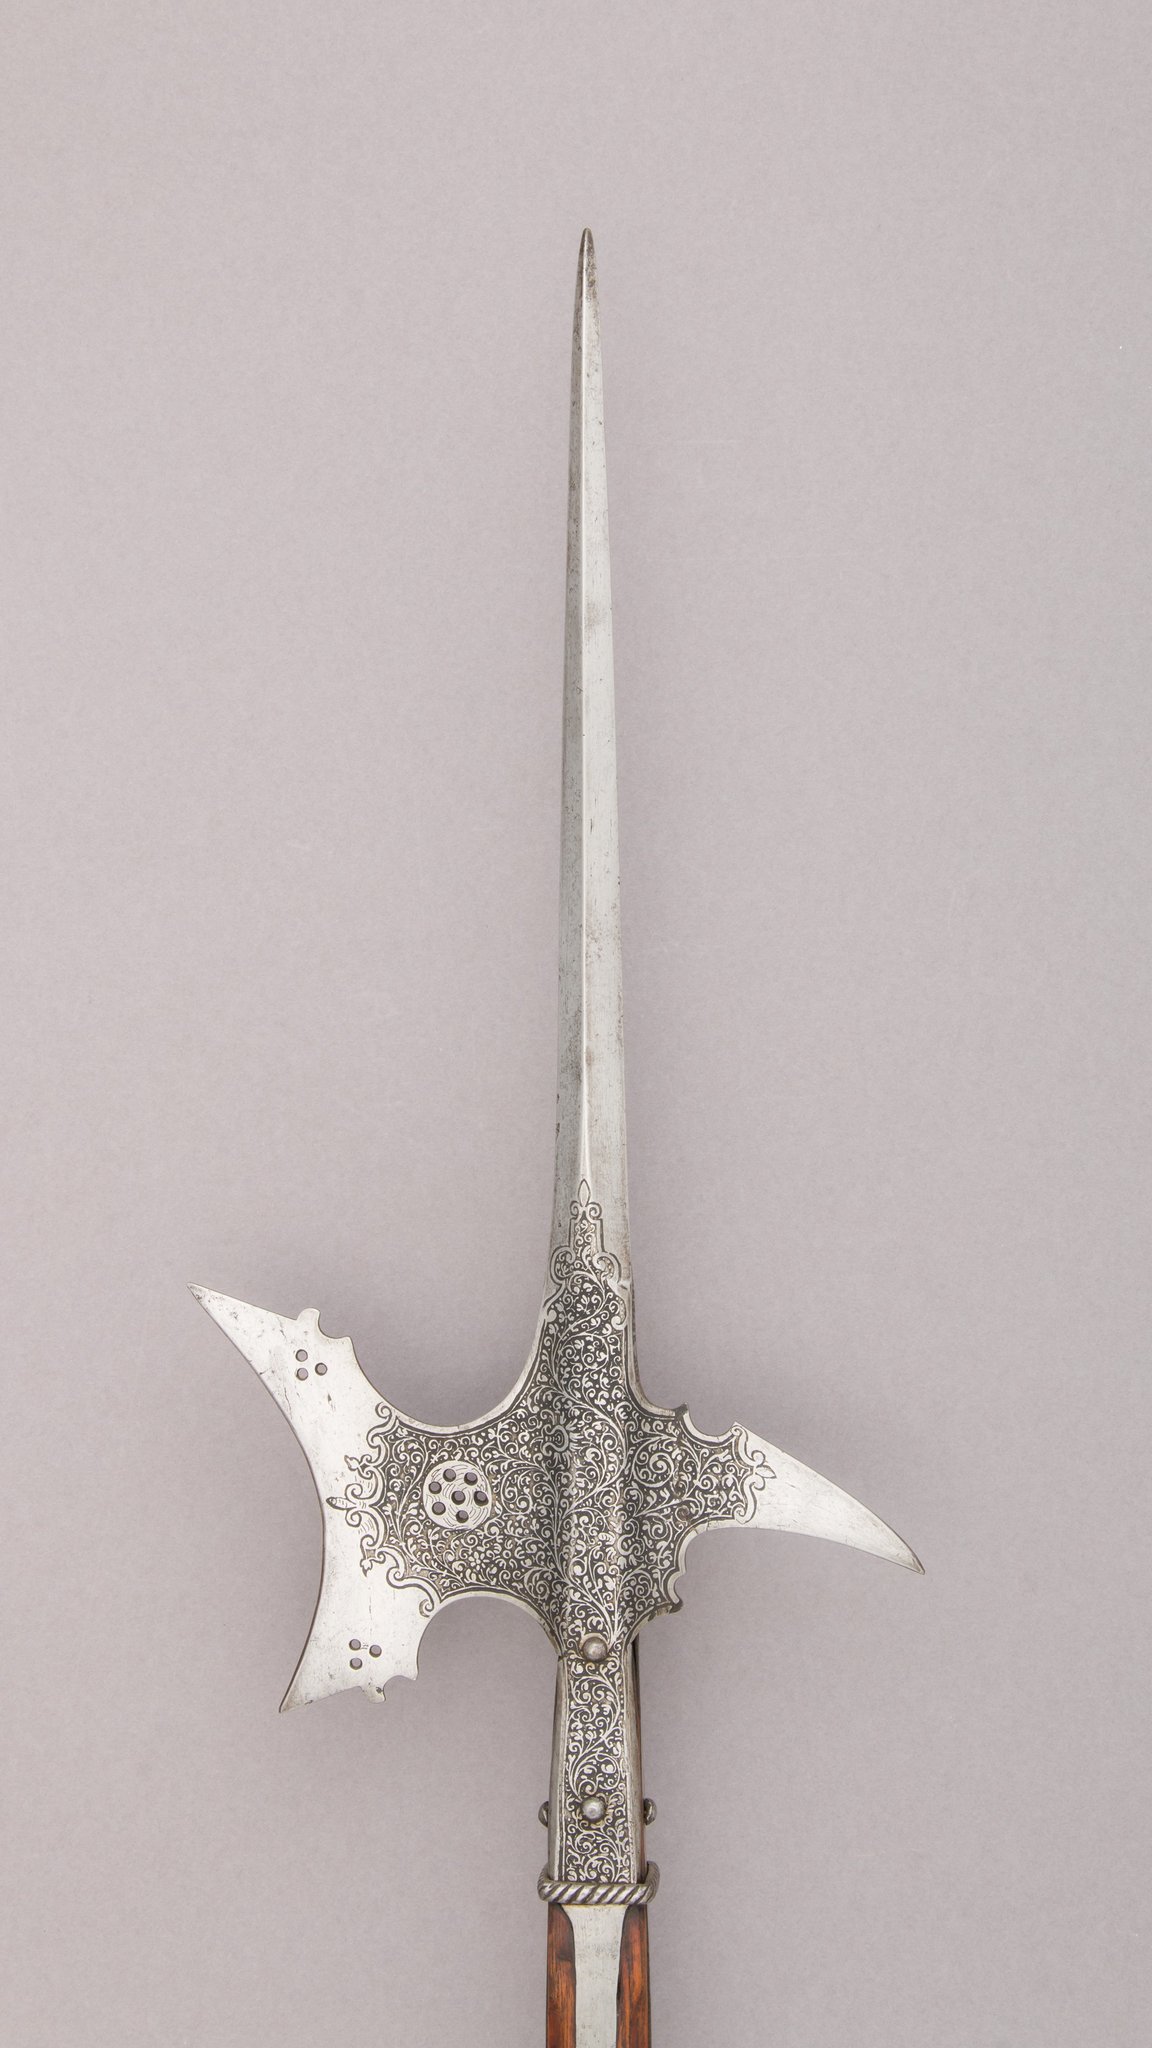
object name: halberd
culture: german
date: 1567-1600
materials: steel, wood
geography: germany